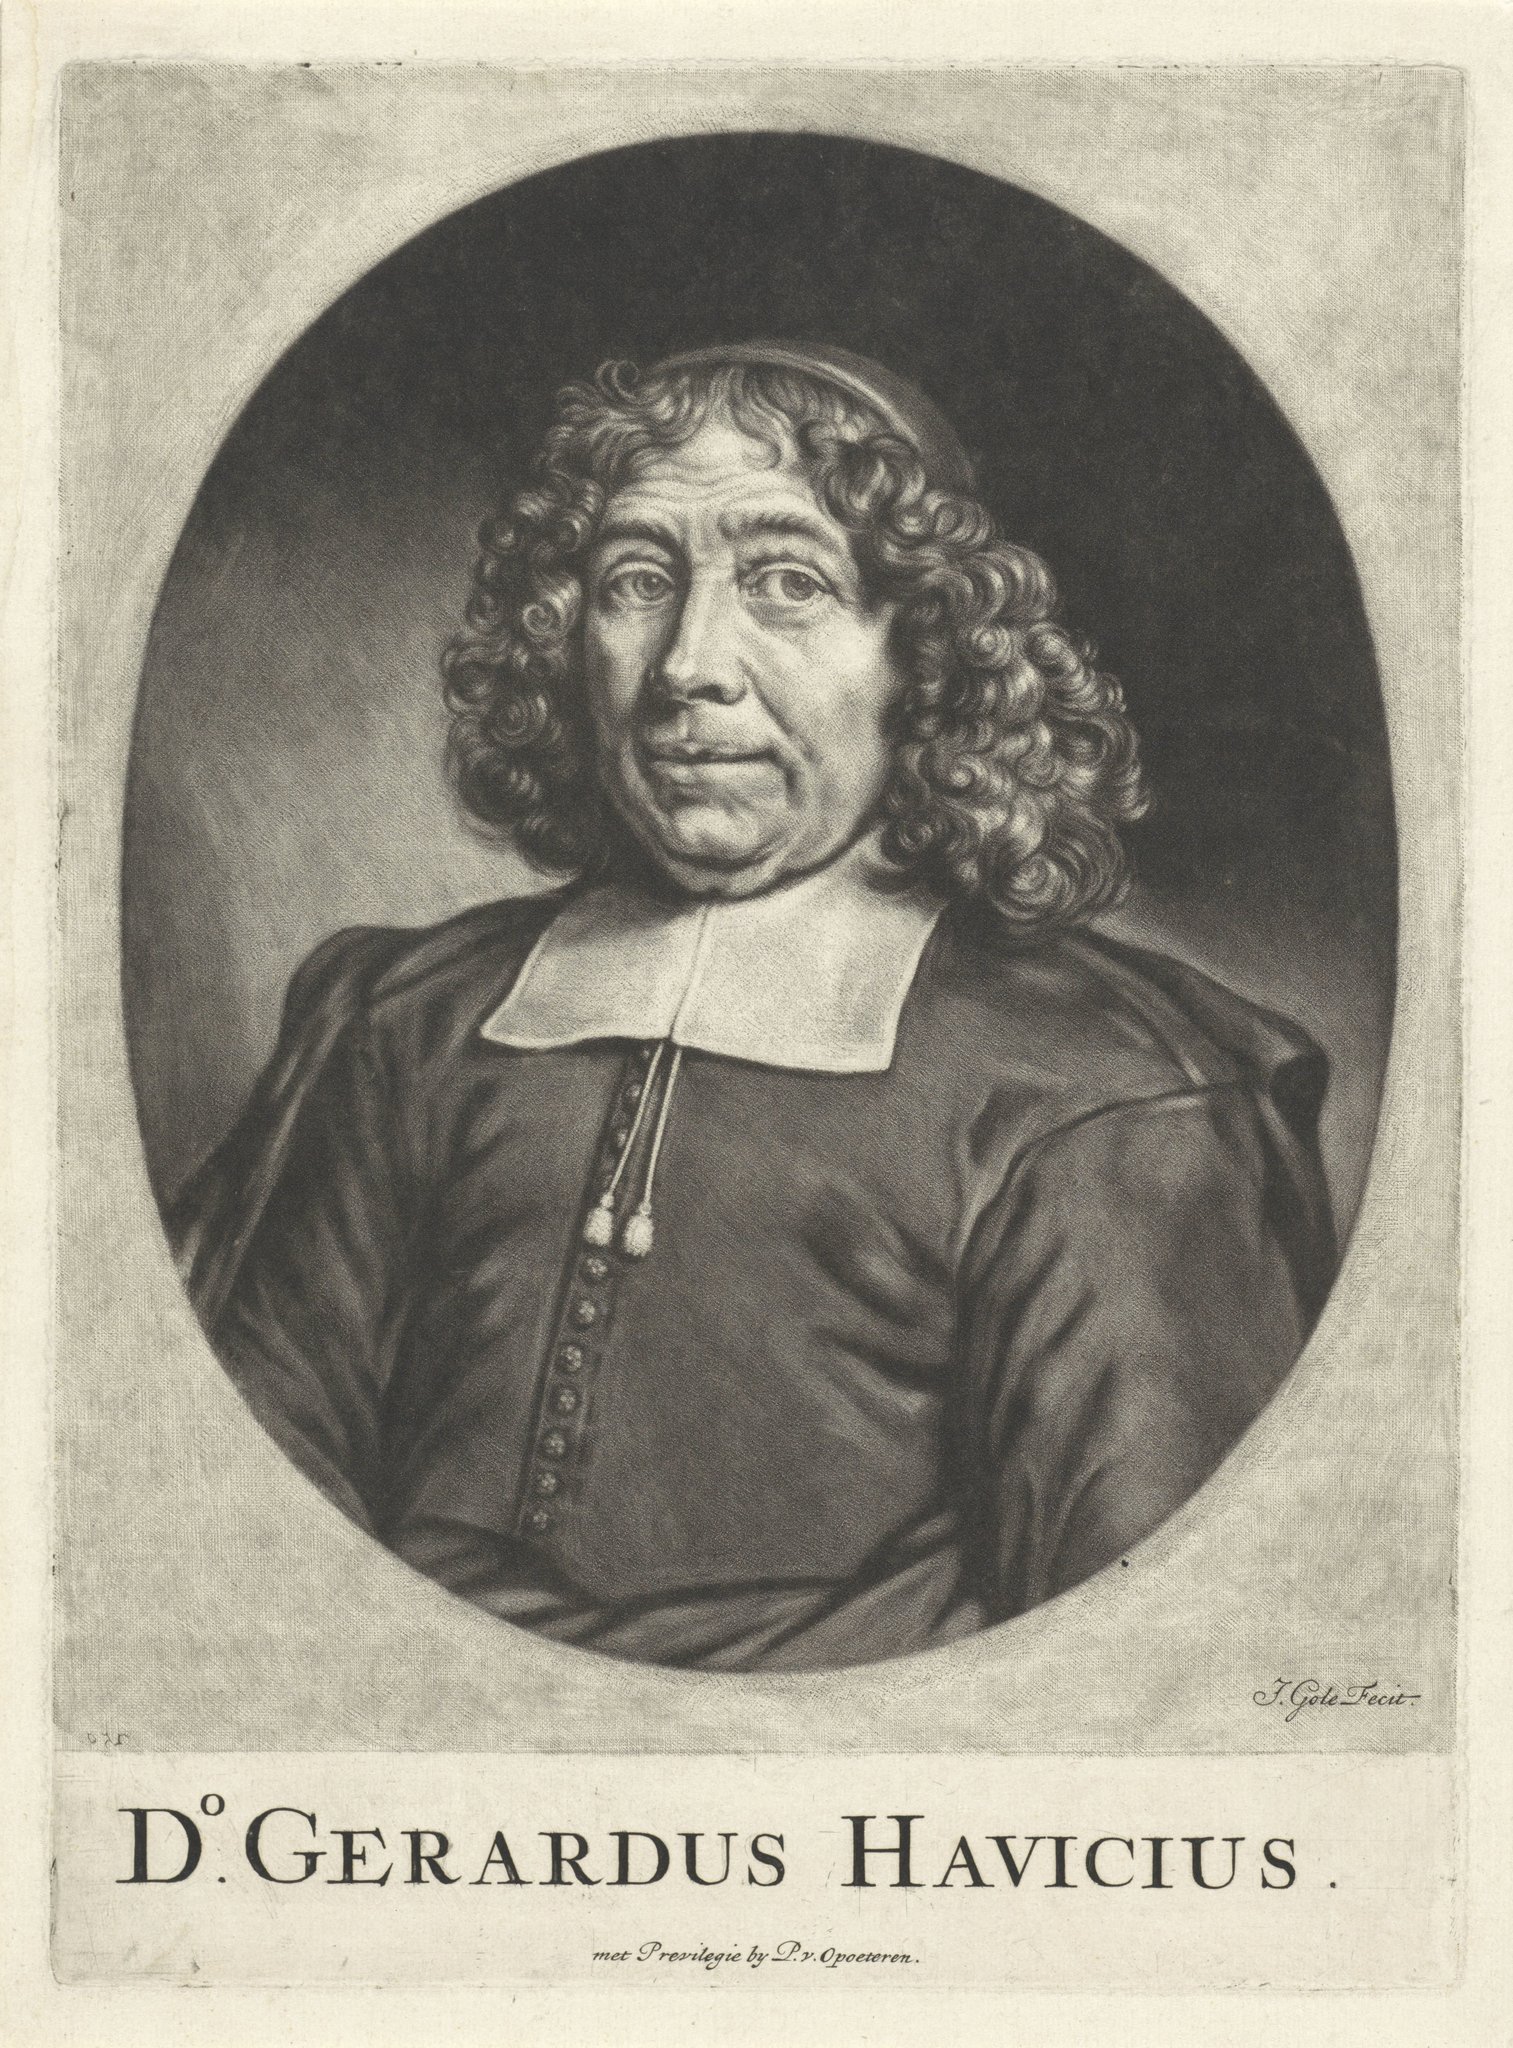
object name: print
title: Portret van Gerard Havicus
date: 1675-1699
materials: paper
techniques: engraving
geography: amsterdam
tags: theoloog, gerard havicus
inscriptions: collector's mark: Lugt 2228